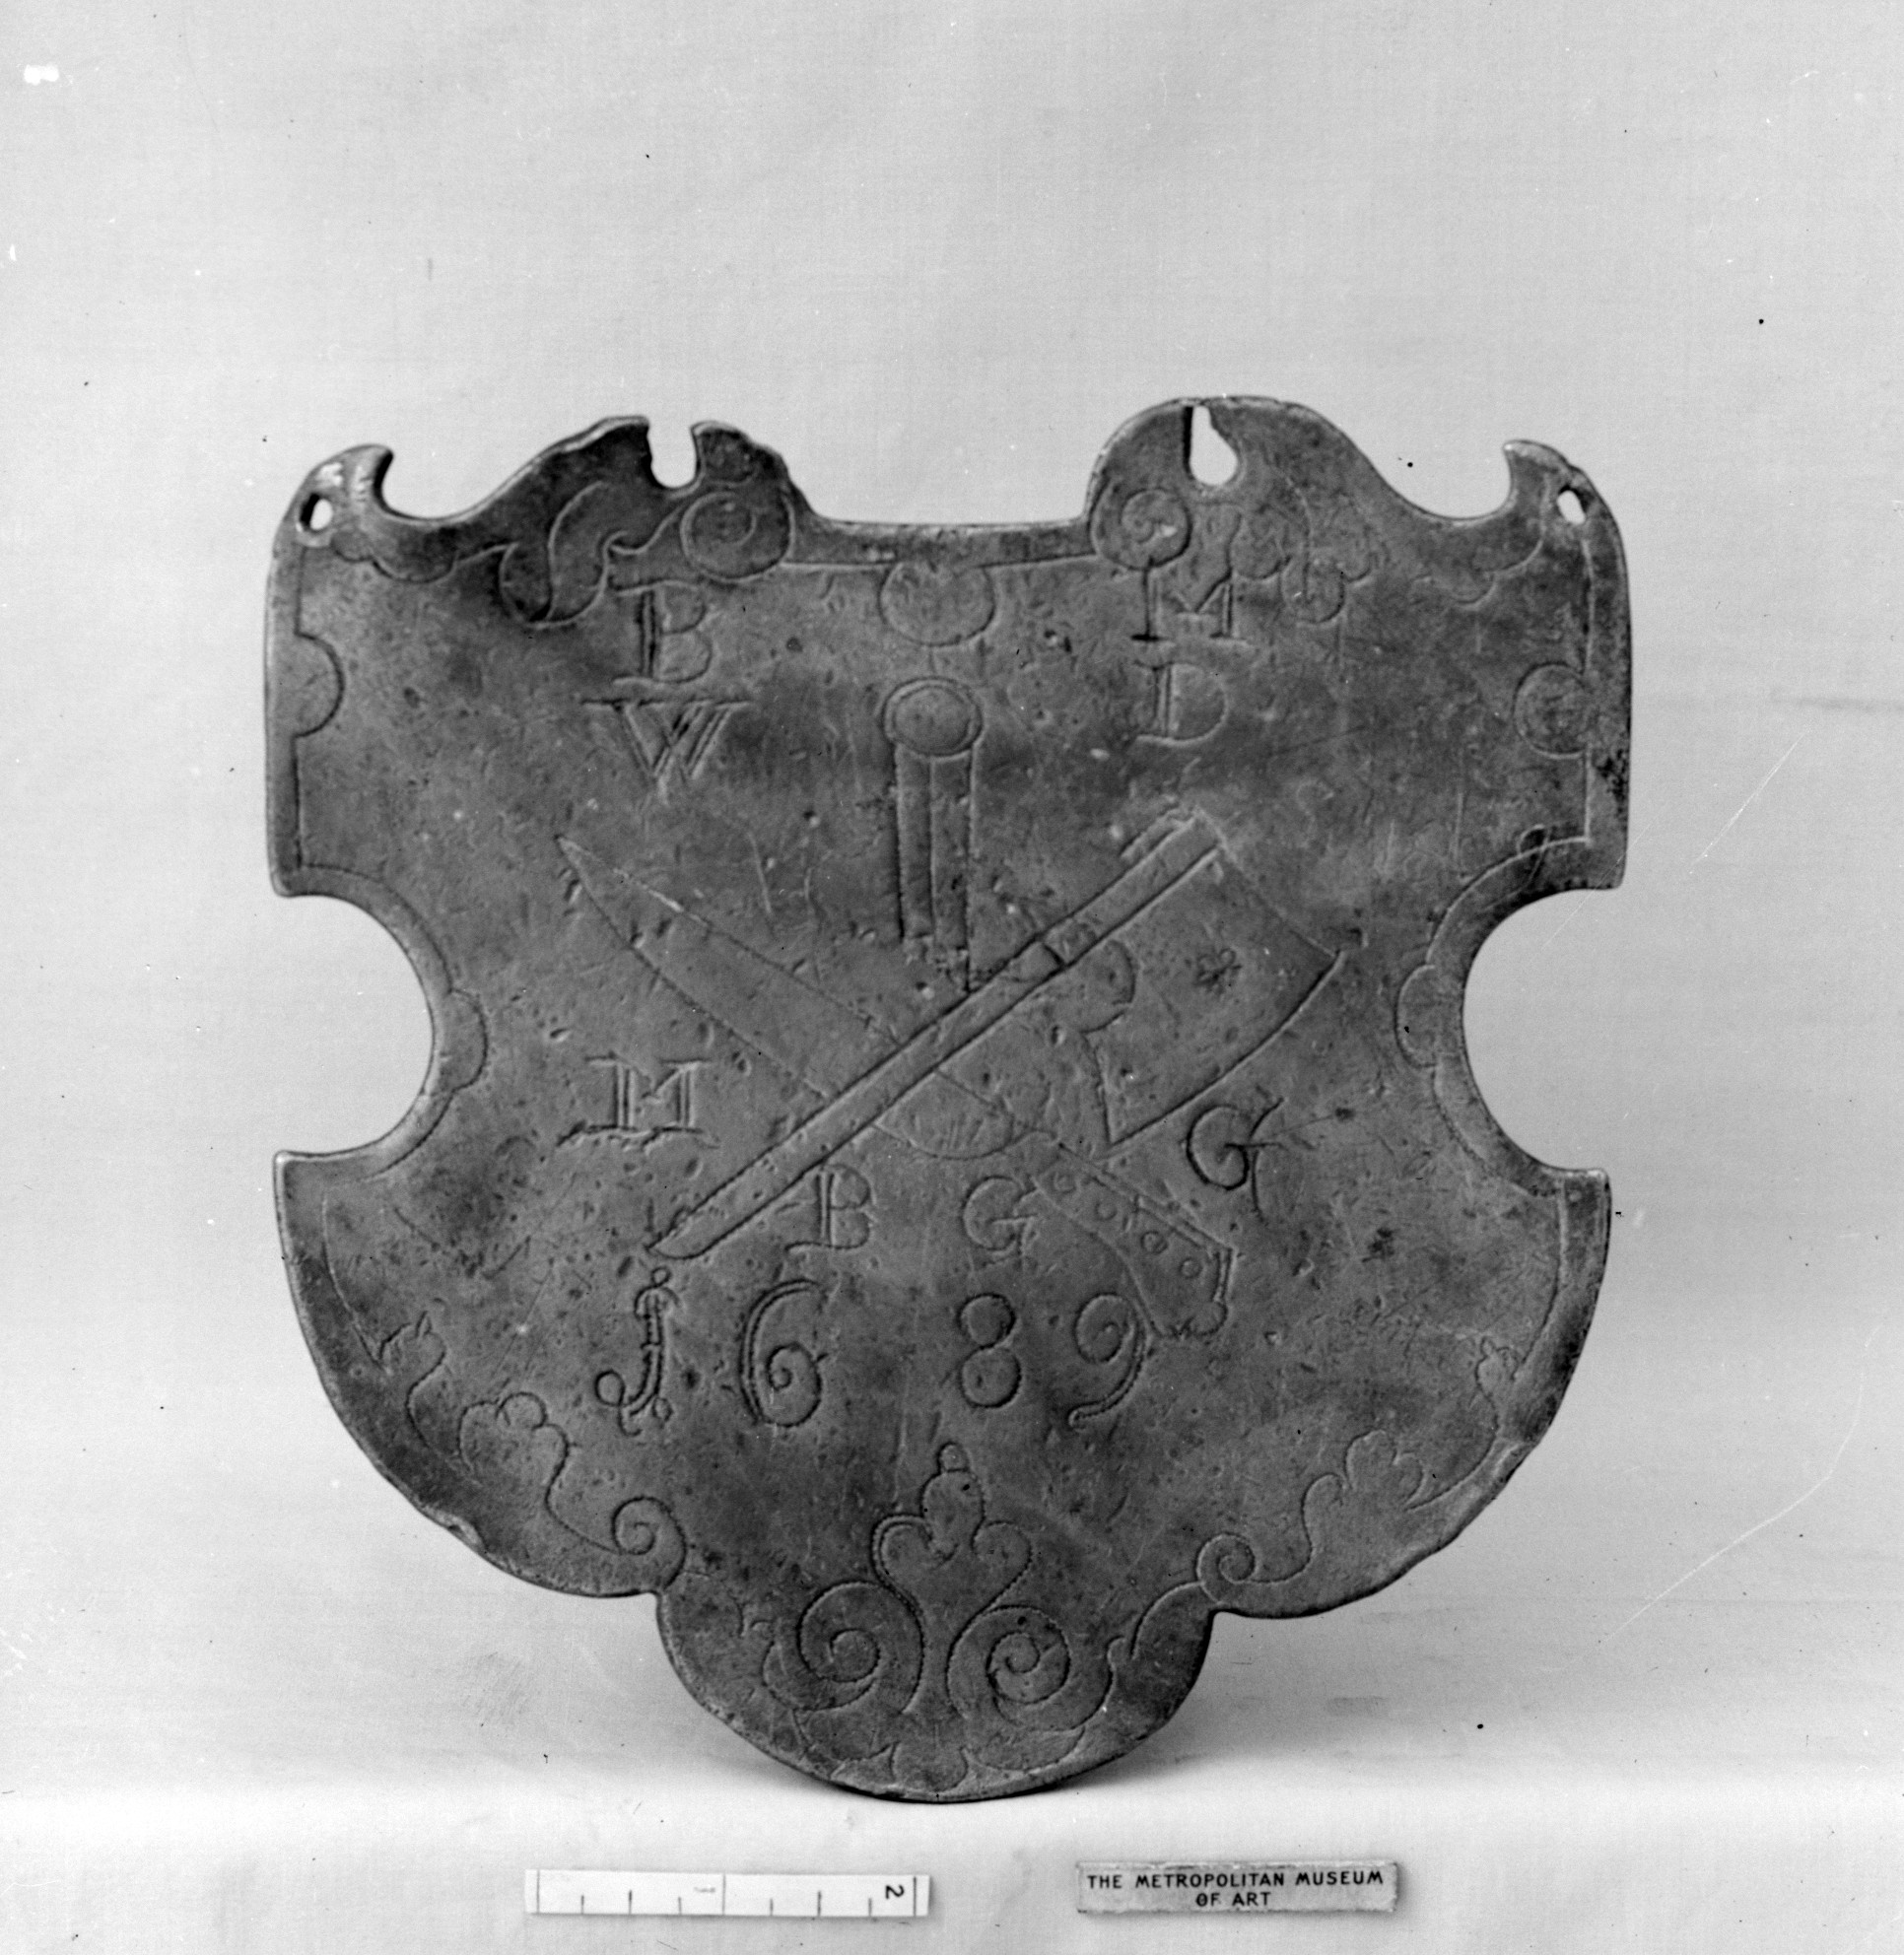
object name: guildsman's or tradesman's badge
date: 1667-1700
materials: pewter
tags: knives,axes